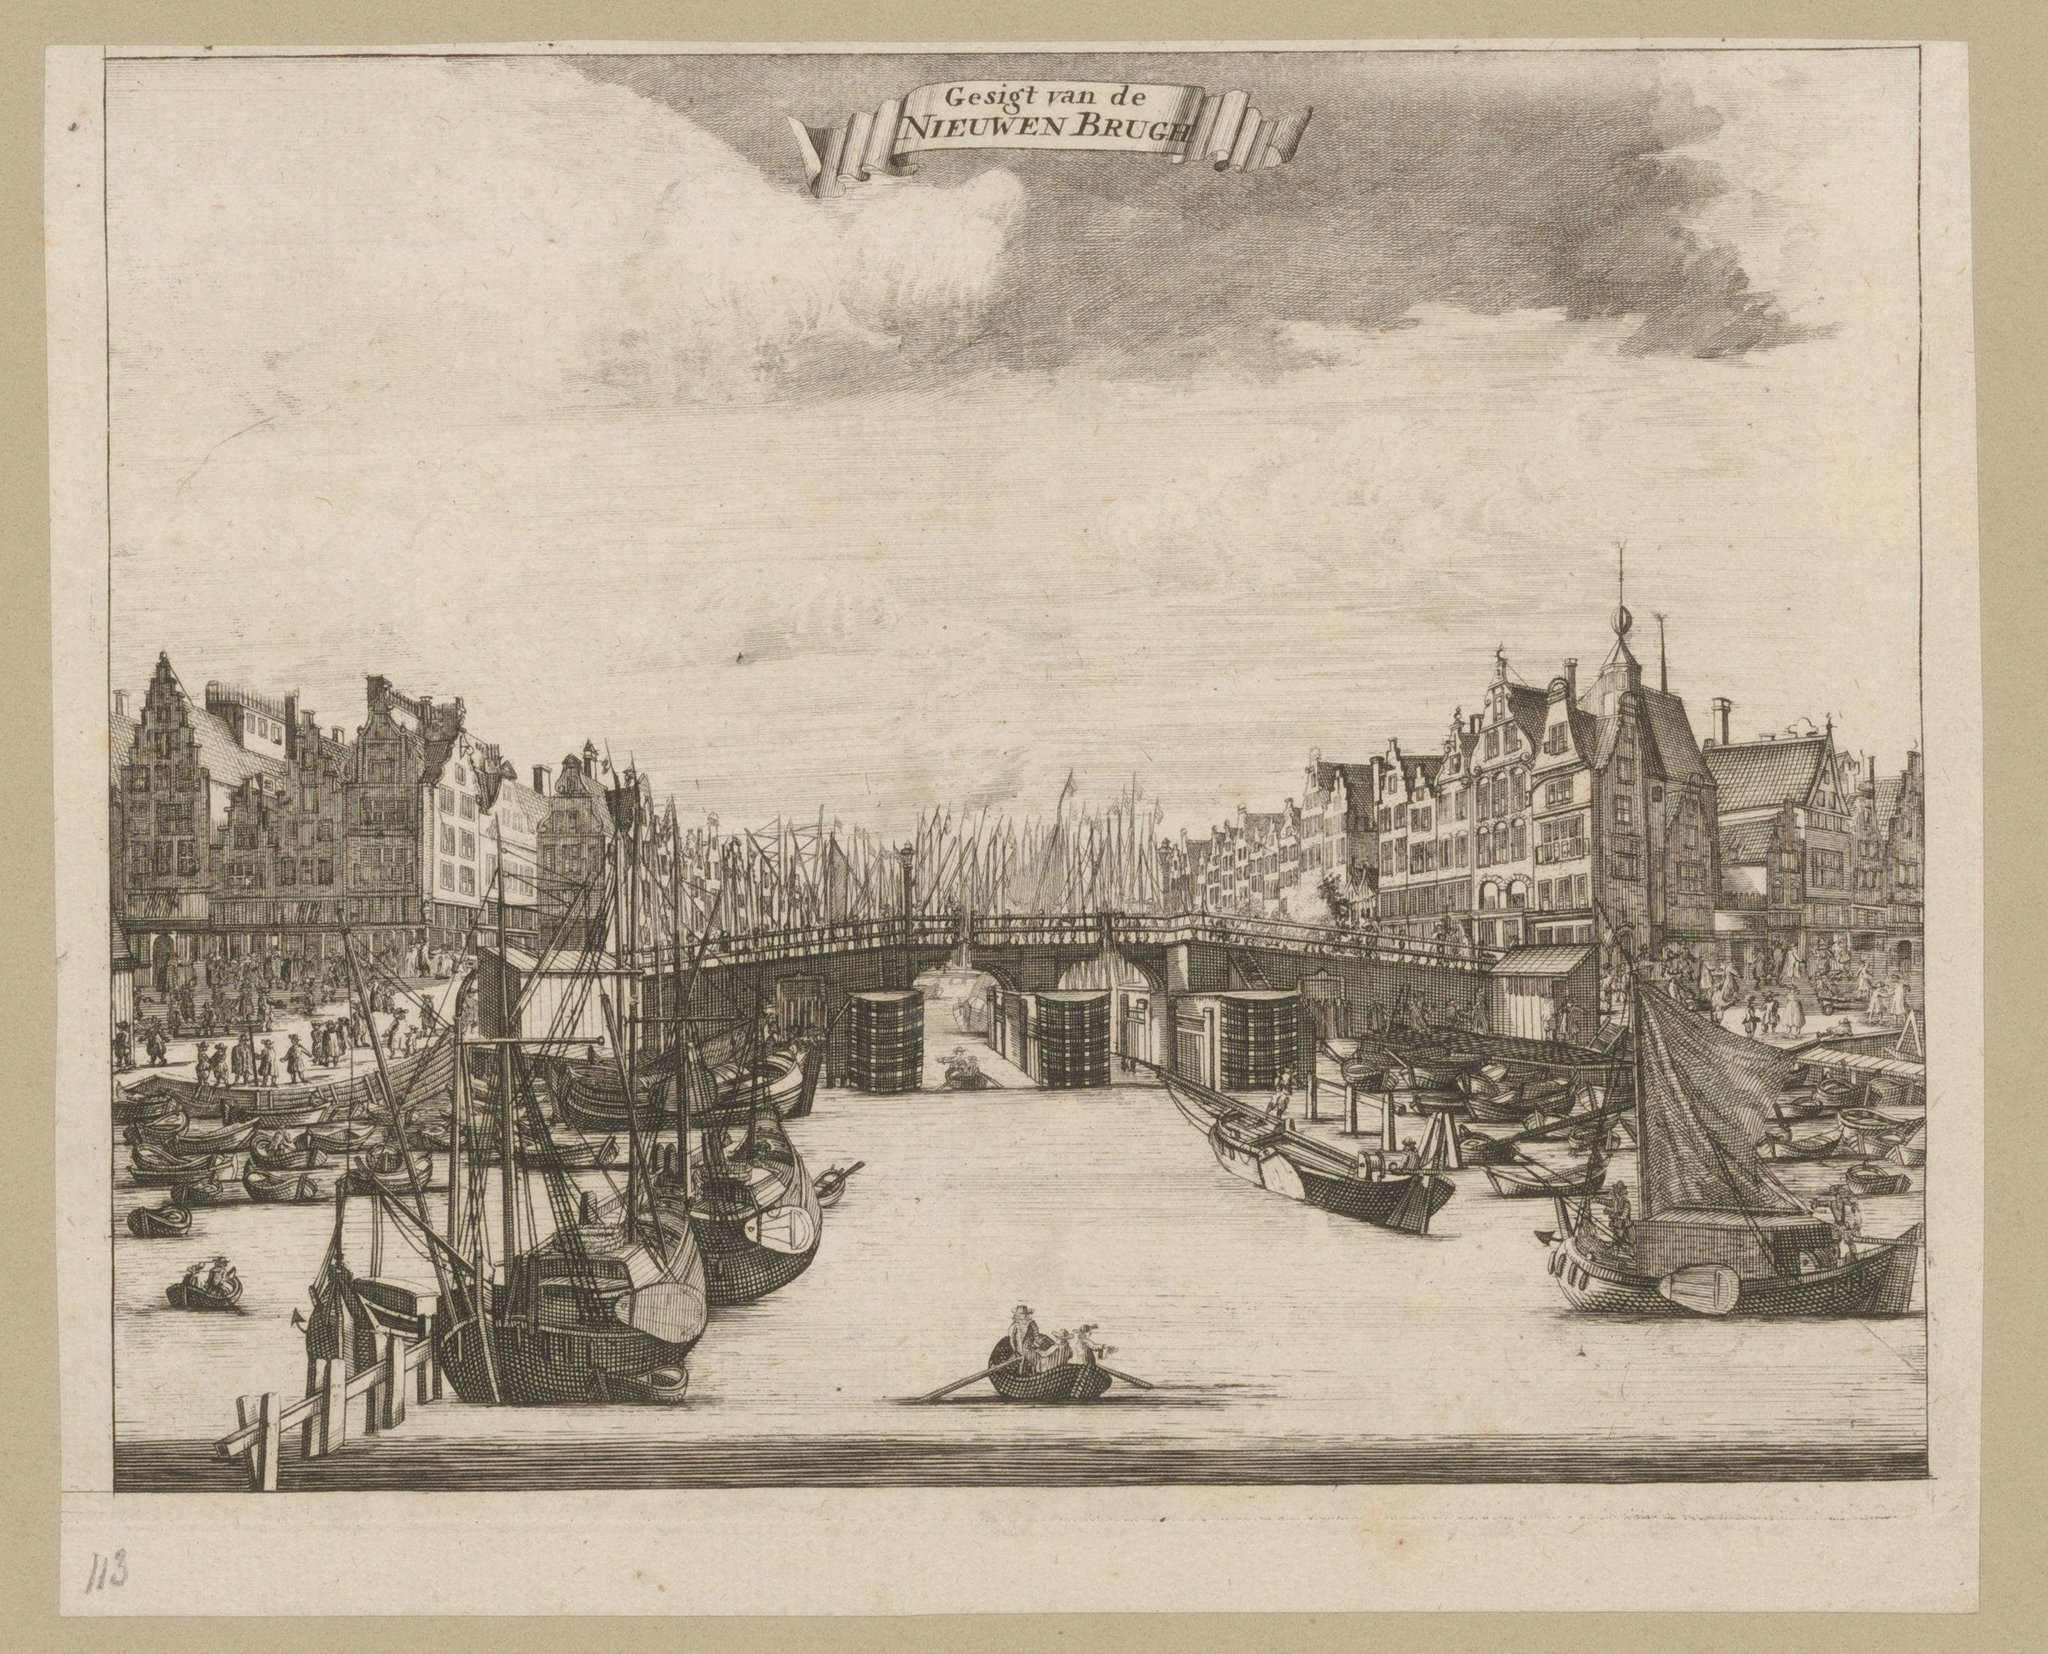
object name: print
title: Gezicht op de Nieuwe Brug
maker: Anonymous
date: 1700-1799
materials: paper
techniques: engraving, etching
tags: city-view in general; 'veduta', canal, bridge in city across river, canal, etc., boat propelled by man or animal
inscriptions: collector's mark: ‘10,59’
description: Onderwerpsrubriek binnen de Atlas Amsterdam: Nieuwe Brug.